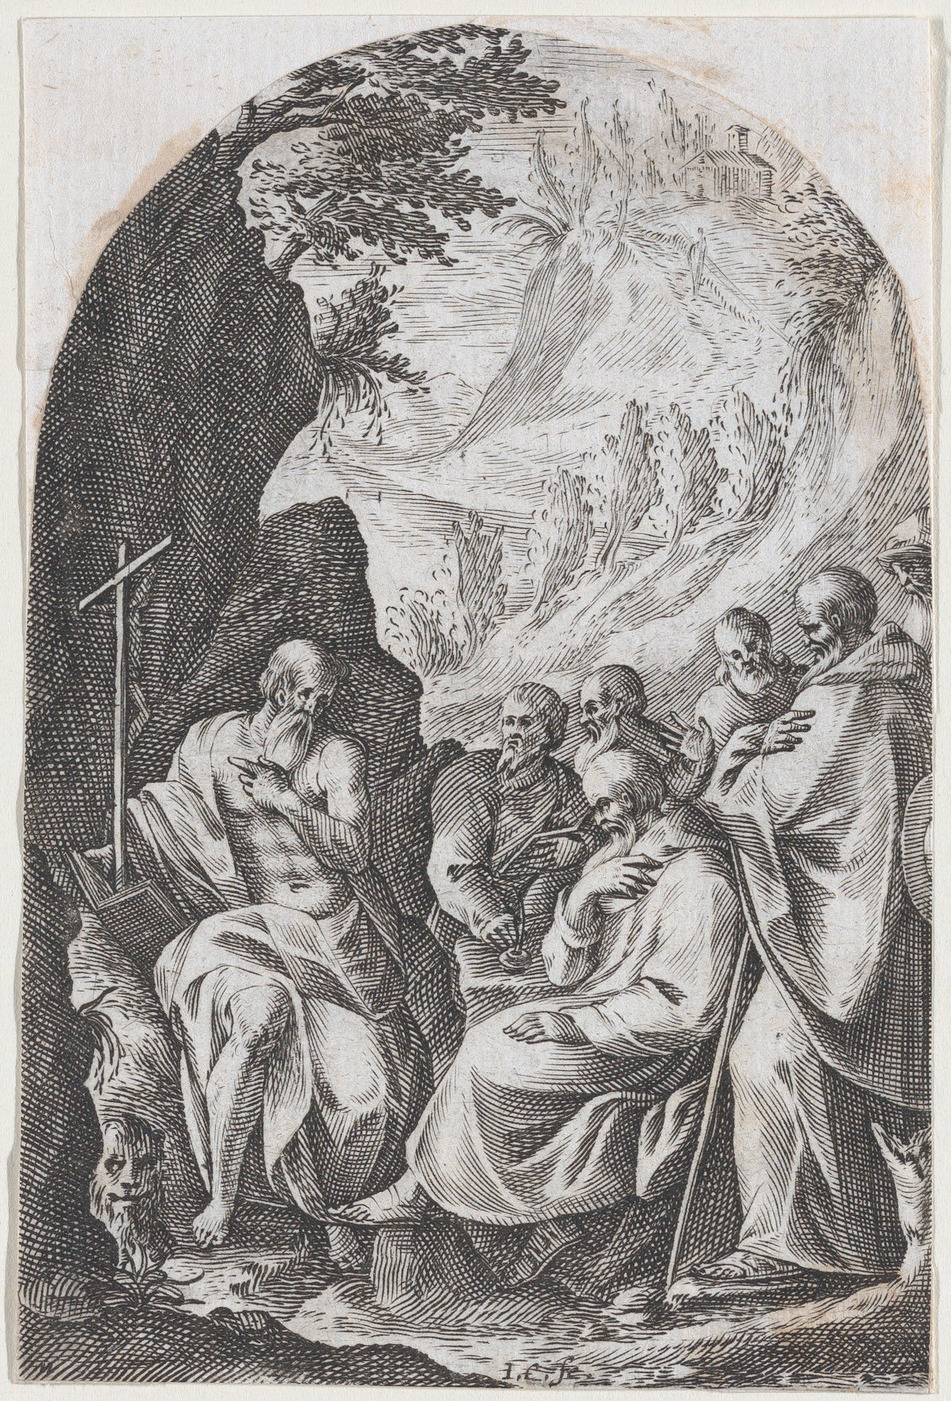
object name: print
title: St. Jerome Instructing his Disciples in the Desert, plate 11 from "Les Tableaux de Rome, Les Eglises Jubilaires" (The Paintings of Rome, The Churches Jubilee)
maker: jacques callot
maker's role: artist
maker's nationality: french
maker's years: 1592-1635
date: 1607-1611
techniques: engraving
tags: men,saint jerome,cross